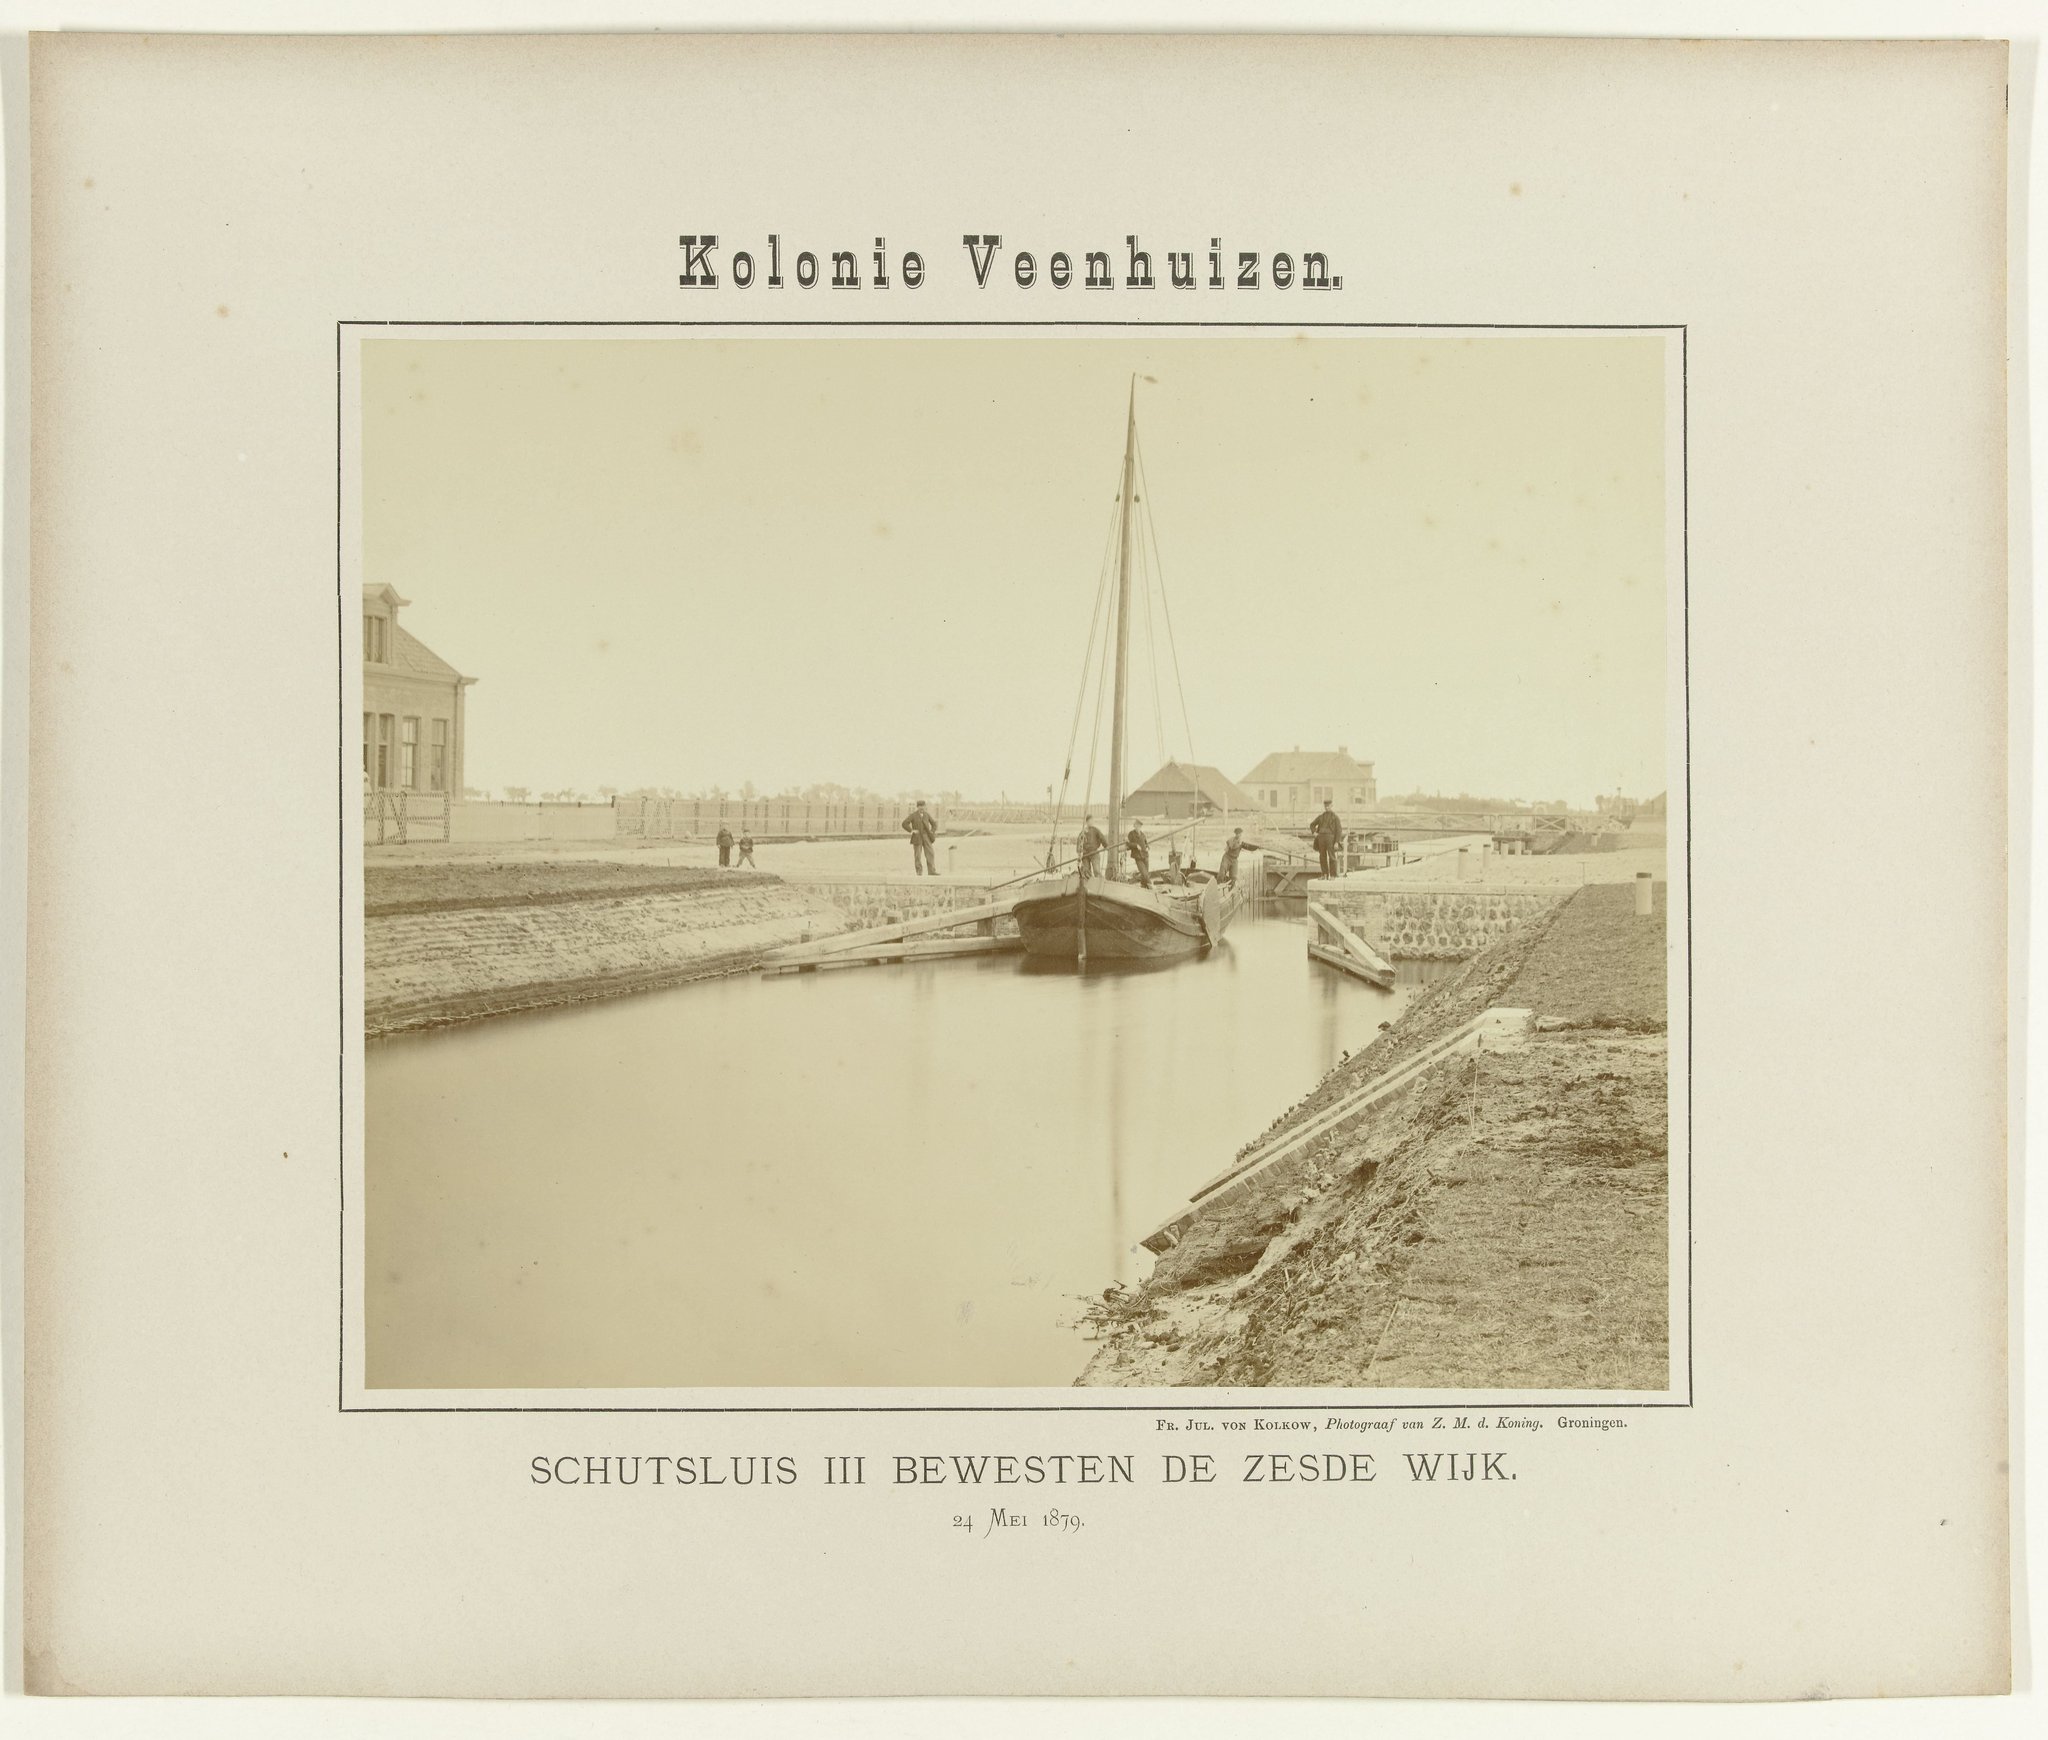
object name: photograph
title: Kolonievaart; afbeelding van Schutsluis nr. 3, te Veenhuizen, gebouwd in 1878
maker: friedrich julius von kolkow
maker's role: fotograaf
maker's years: 1839-1914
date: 1879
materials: cardboard, paper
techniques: photography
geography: groningen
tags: veenhuizen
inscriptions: date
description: De schutsluis werd gebouwd in opdracht van de provincie Drenthe. Er werd zonder machines gewerkt; ook het heien gebeurde met mankracht. De Veenhuizervaart was belangrijk voor het vervoer van de produkten van de kolonie Veenhuizen. Daar werden behoeftige stedelingen omgeschoold tot degelijke boeren.